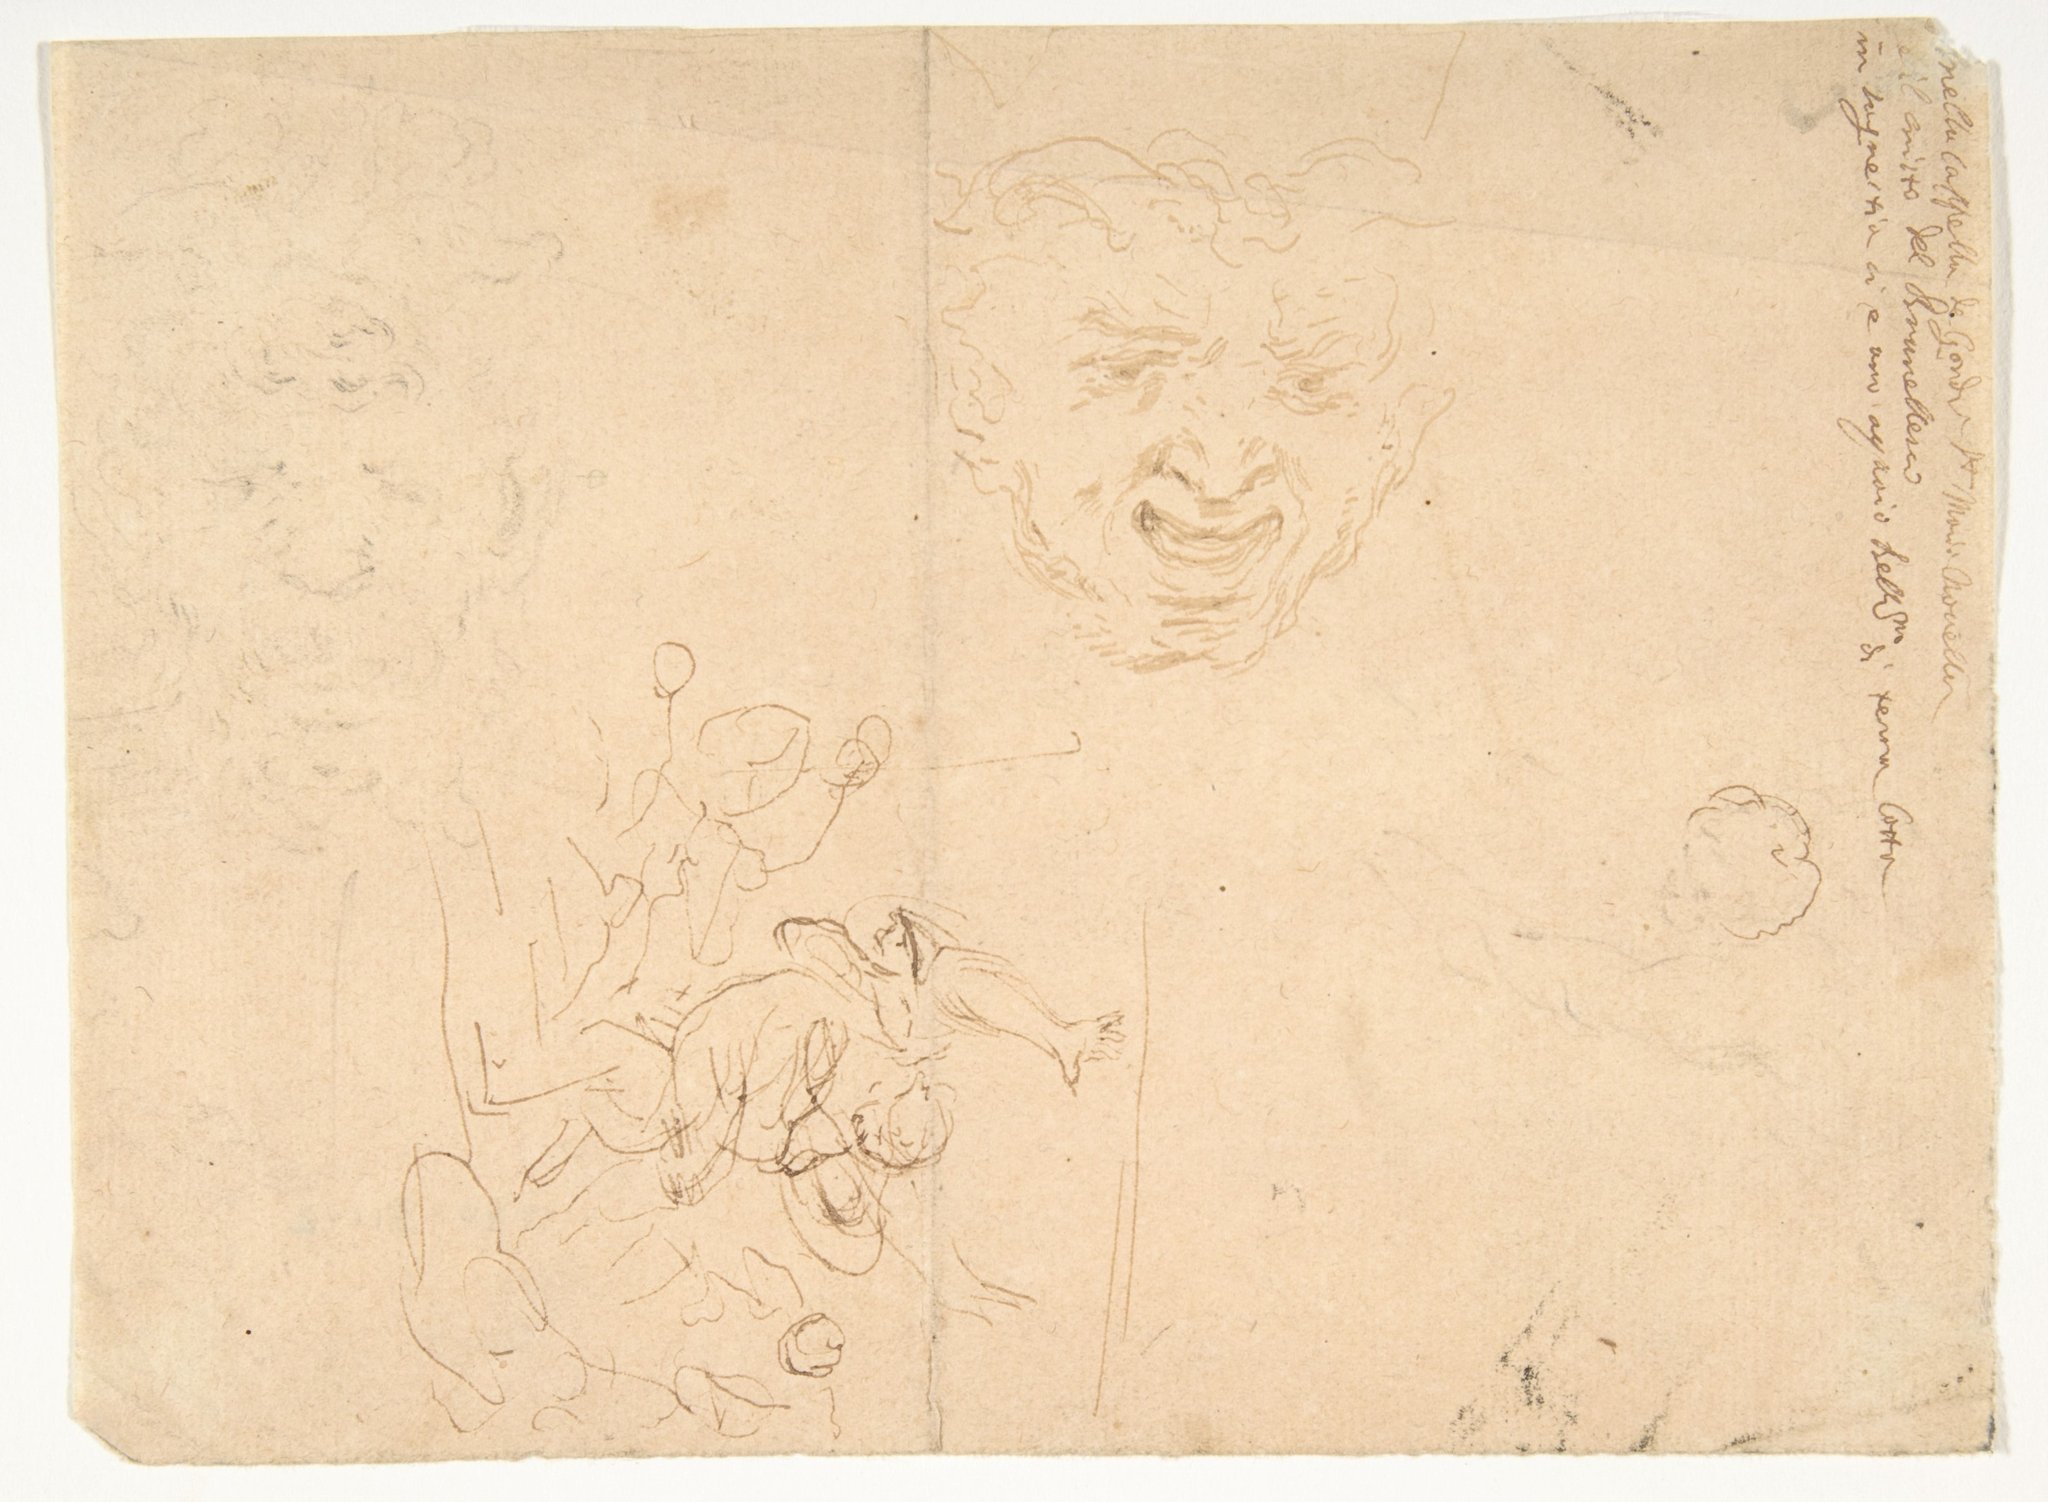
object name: drawing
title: Head of a Satyr and Other Figure Studies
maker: stefano della bella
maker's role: artist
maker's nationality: italian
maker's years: 1610-1664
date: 1610-1664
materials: ink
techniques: pen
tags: heads,satyrs